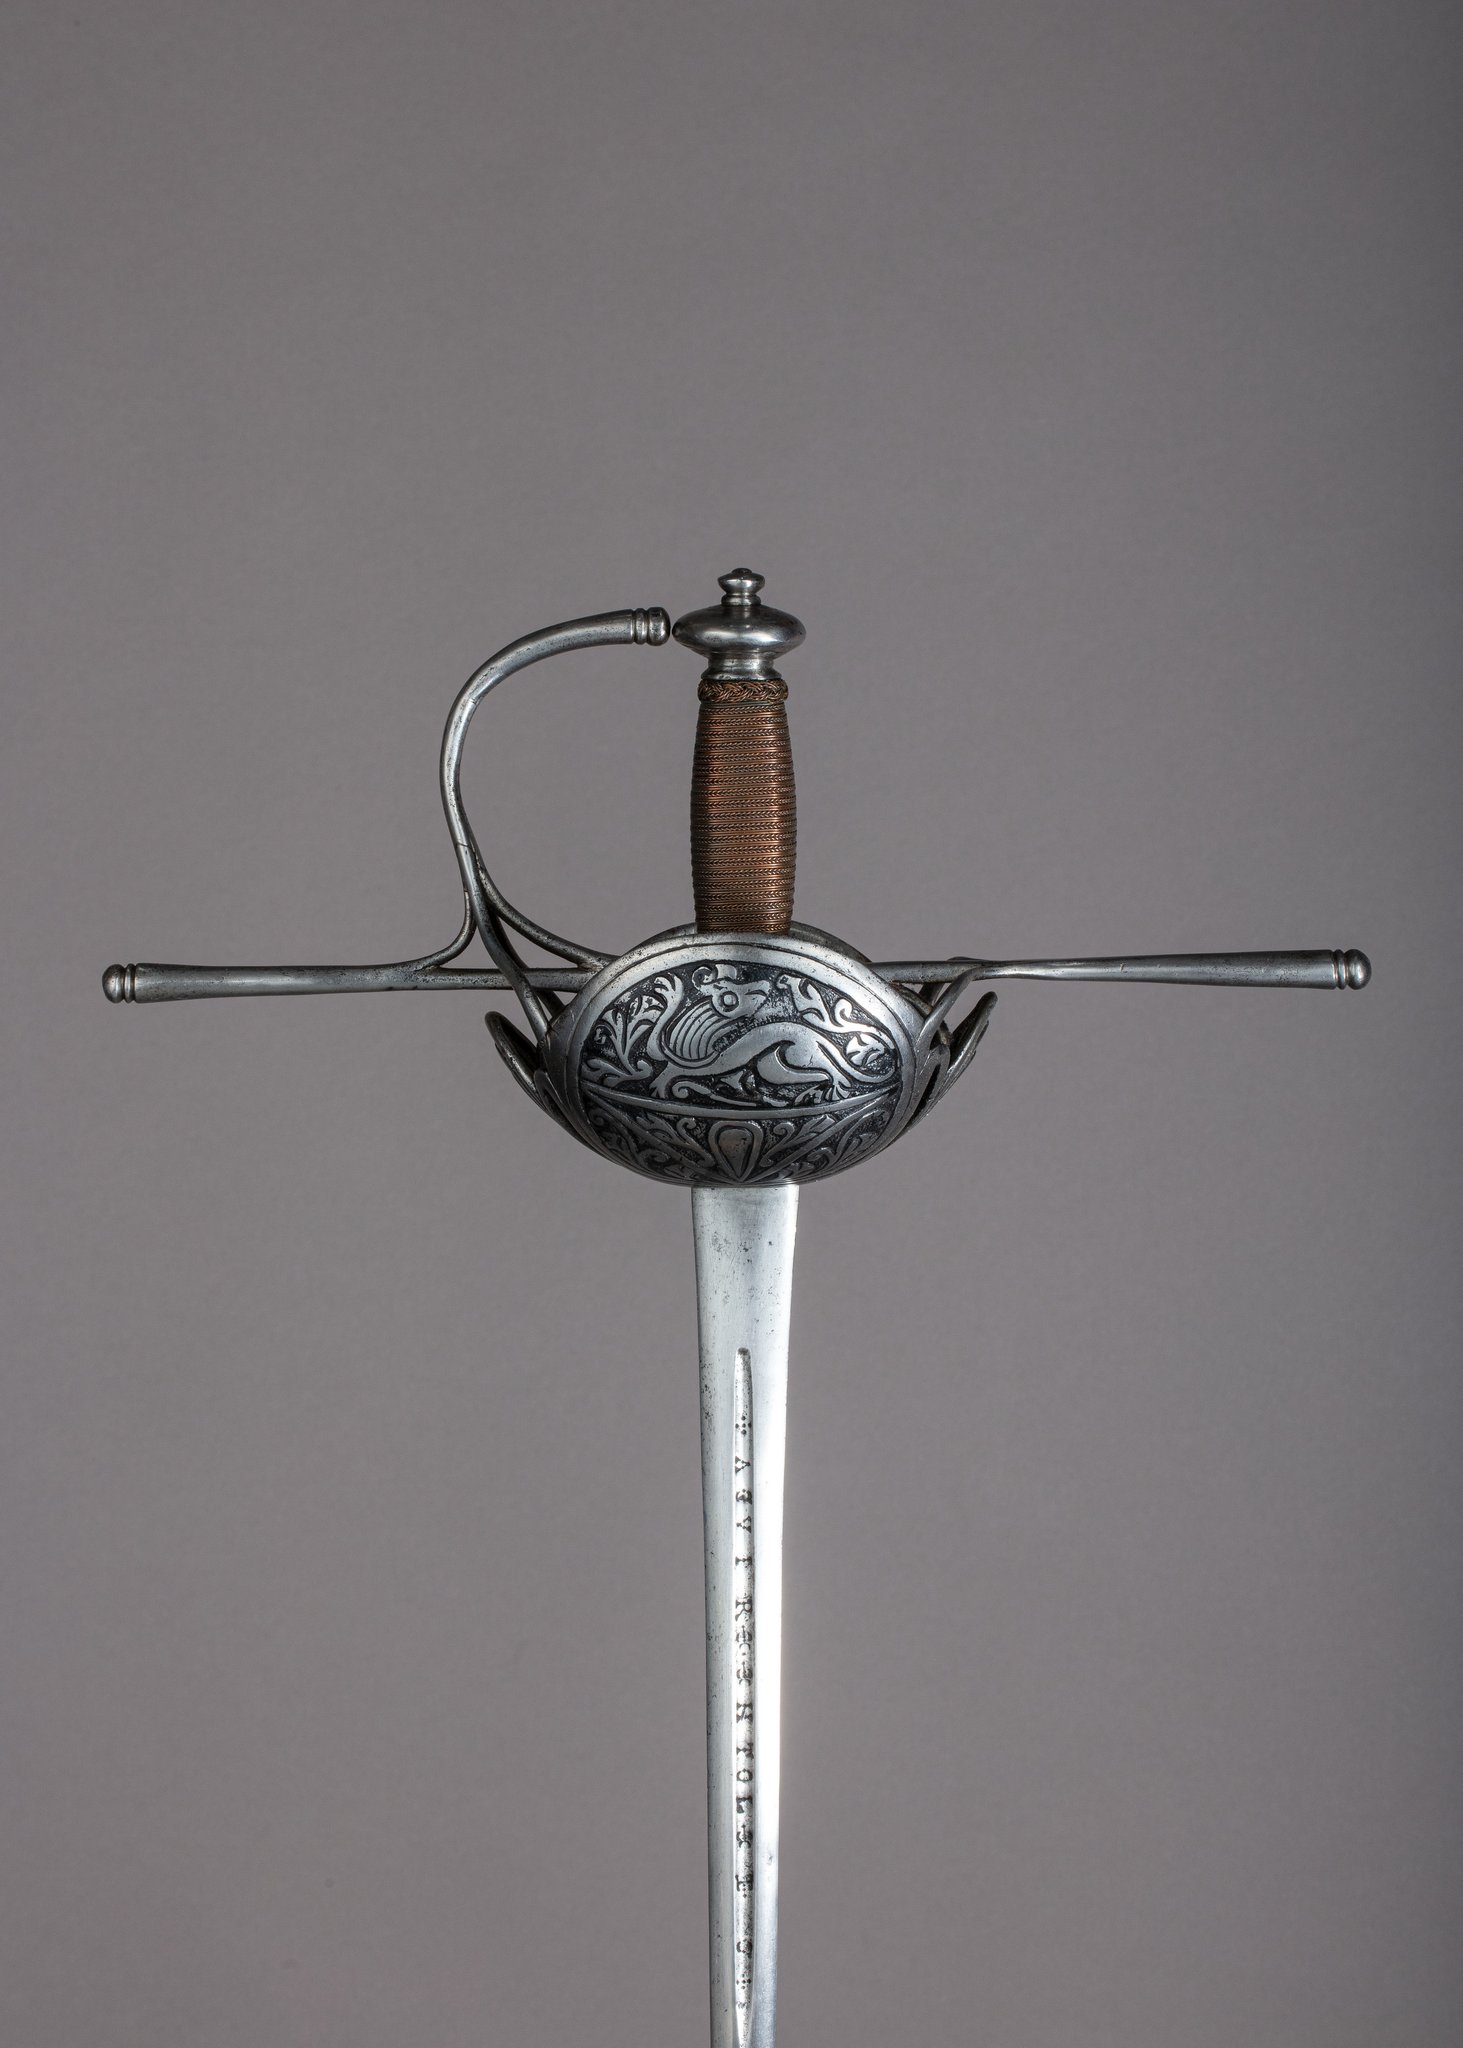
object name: cup hilted rapier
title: Cup-Hilted Rapier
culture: spanish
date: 1650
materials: copper, steel, metal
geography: spain